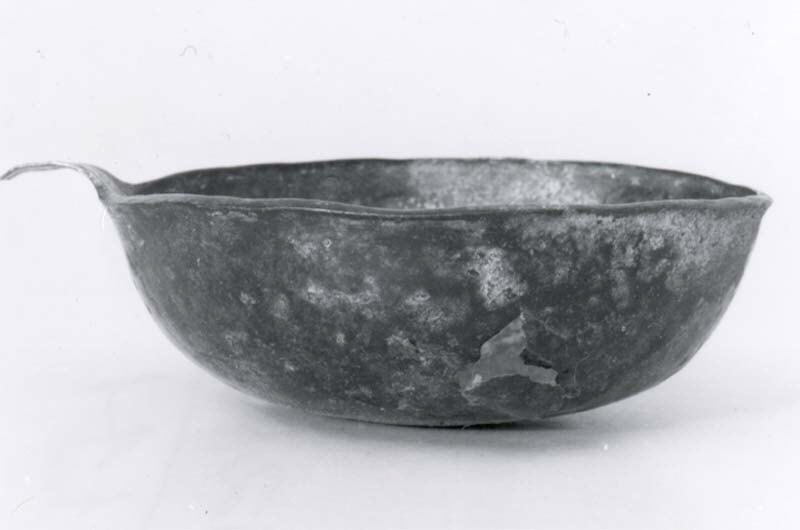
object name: vessel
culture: hattian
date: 2300-2000 BCE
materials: bronze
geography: central anatolia